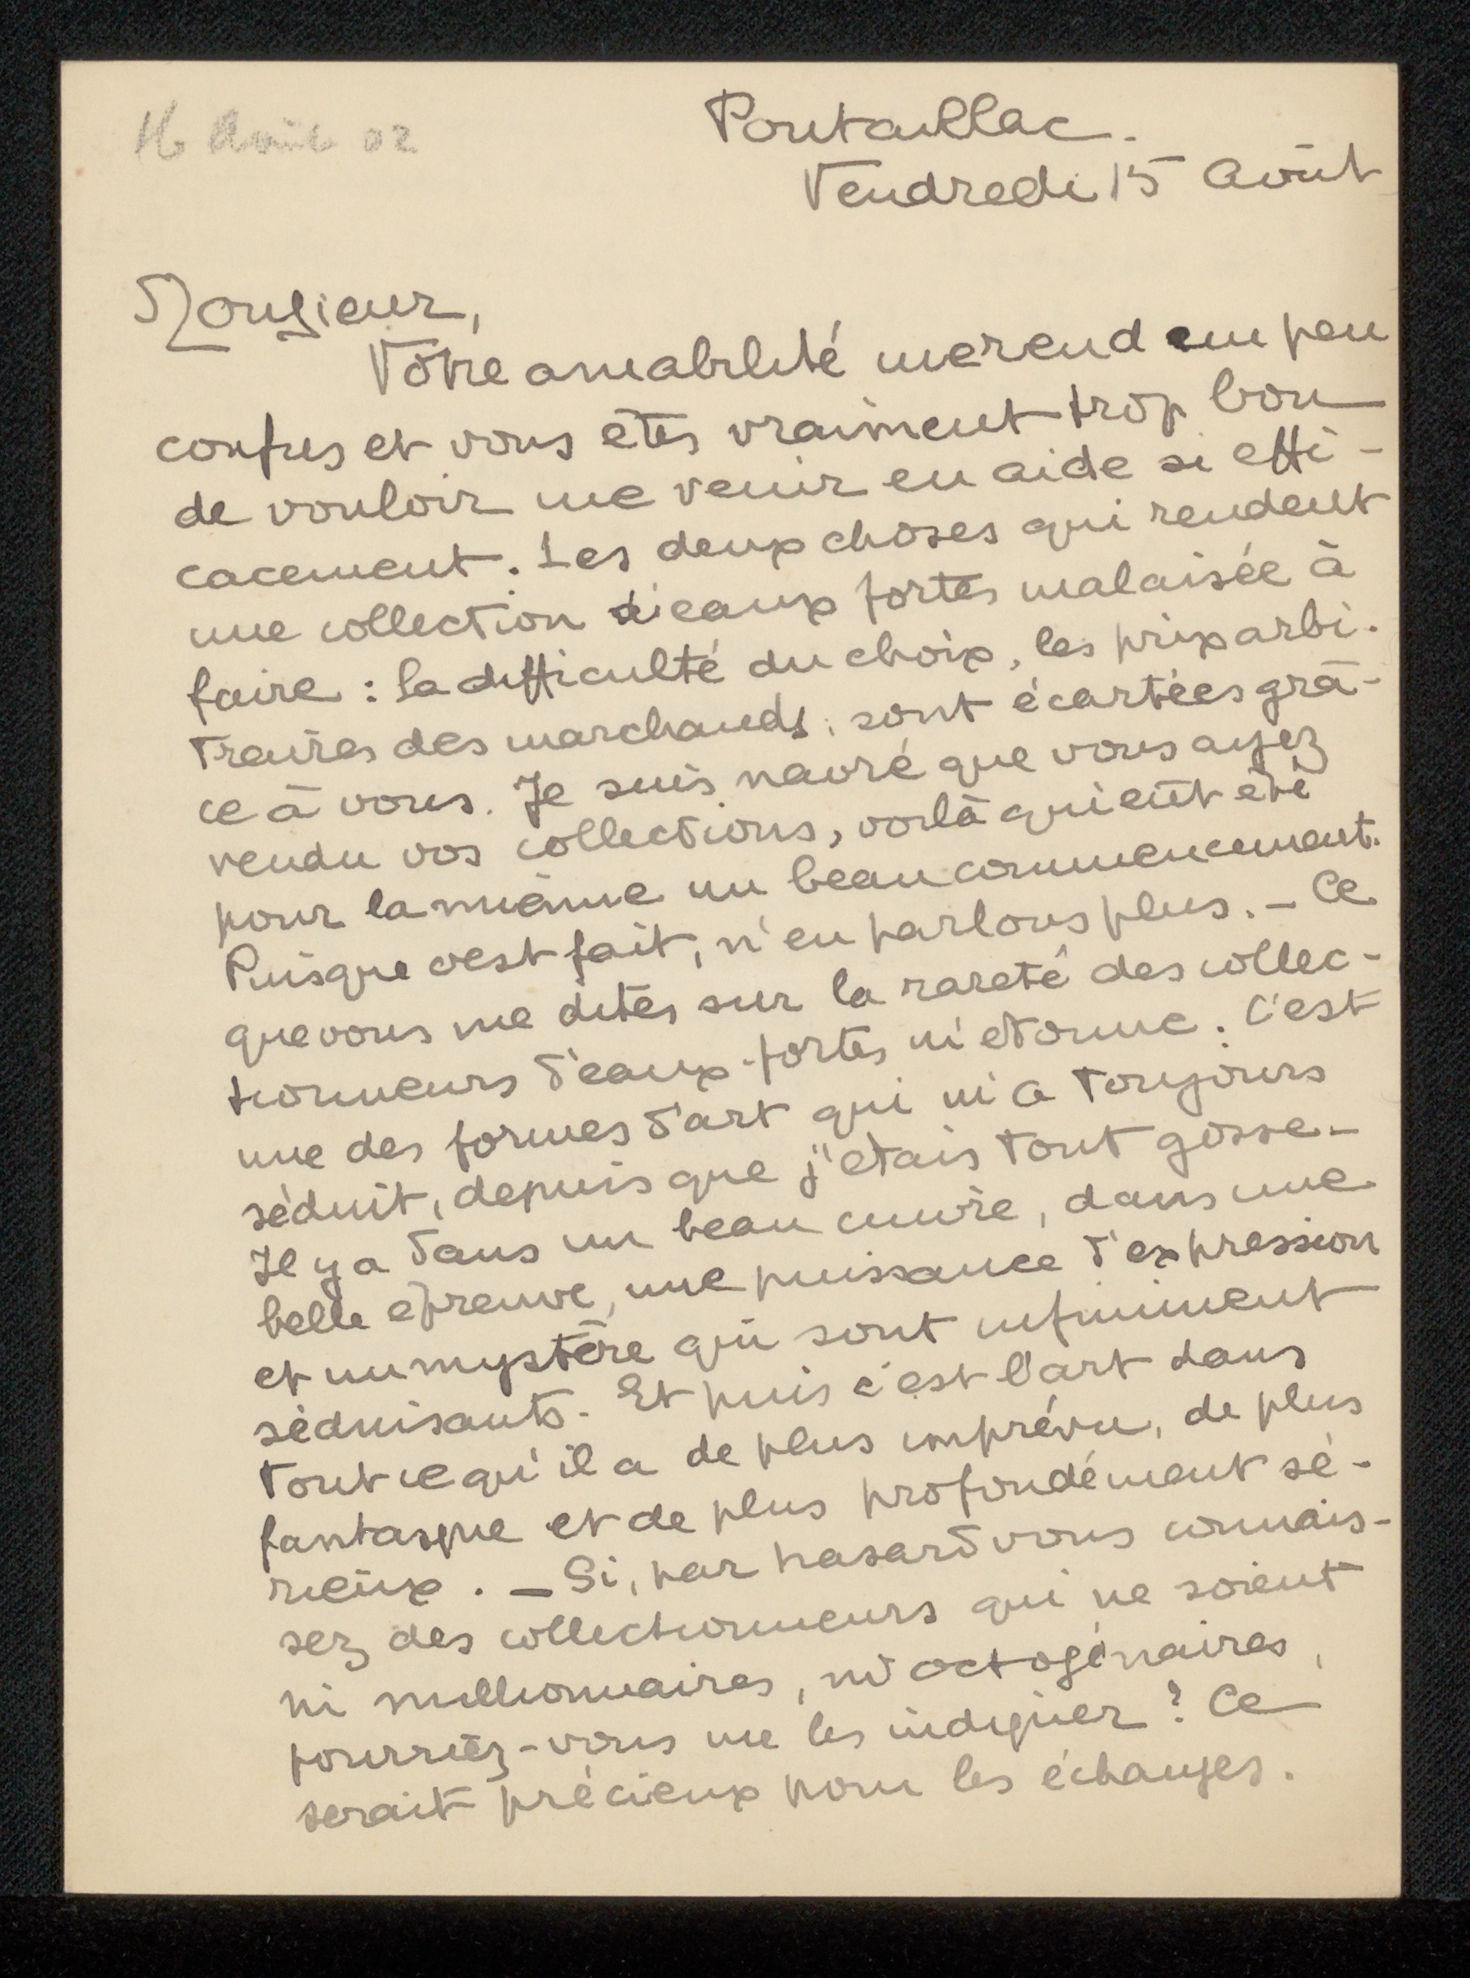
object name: letter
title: Brief aan Philip Zilcken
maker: auguste graaf van gilbert de voisins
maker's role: essayist, schrijver, vertaler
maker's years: 1877-1939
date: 1902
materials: ink, paper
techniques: pen, writing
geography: pontaillac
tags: félix hilaire buhot, print maker, draughtsman, käthe kollwitz, the hague, philip zilcken, the graphic arts, art collecting, netherlands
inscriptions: collector's mark: ‘RPK’